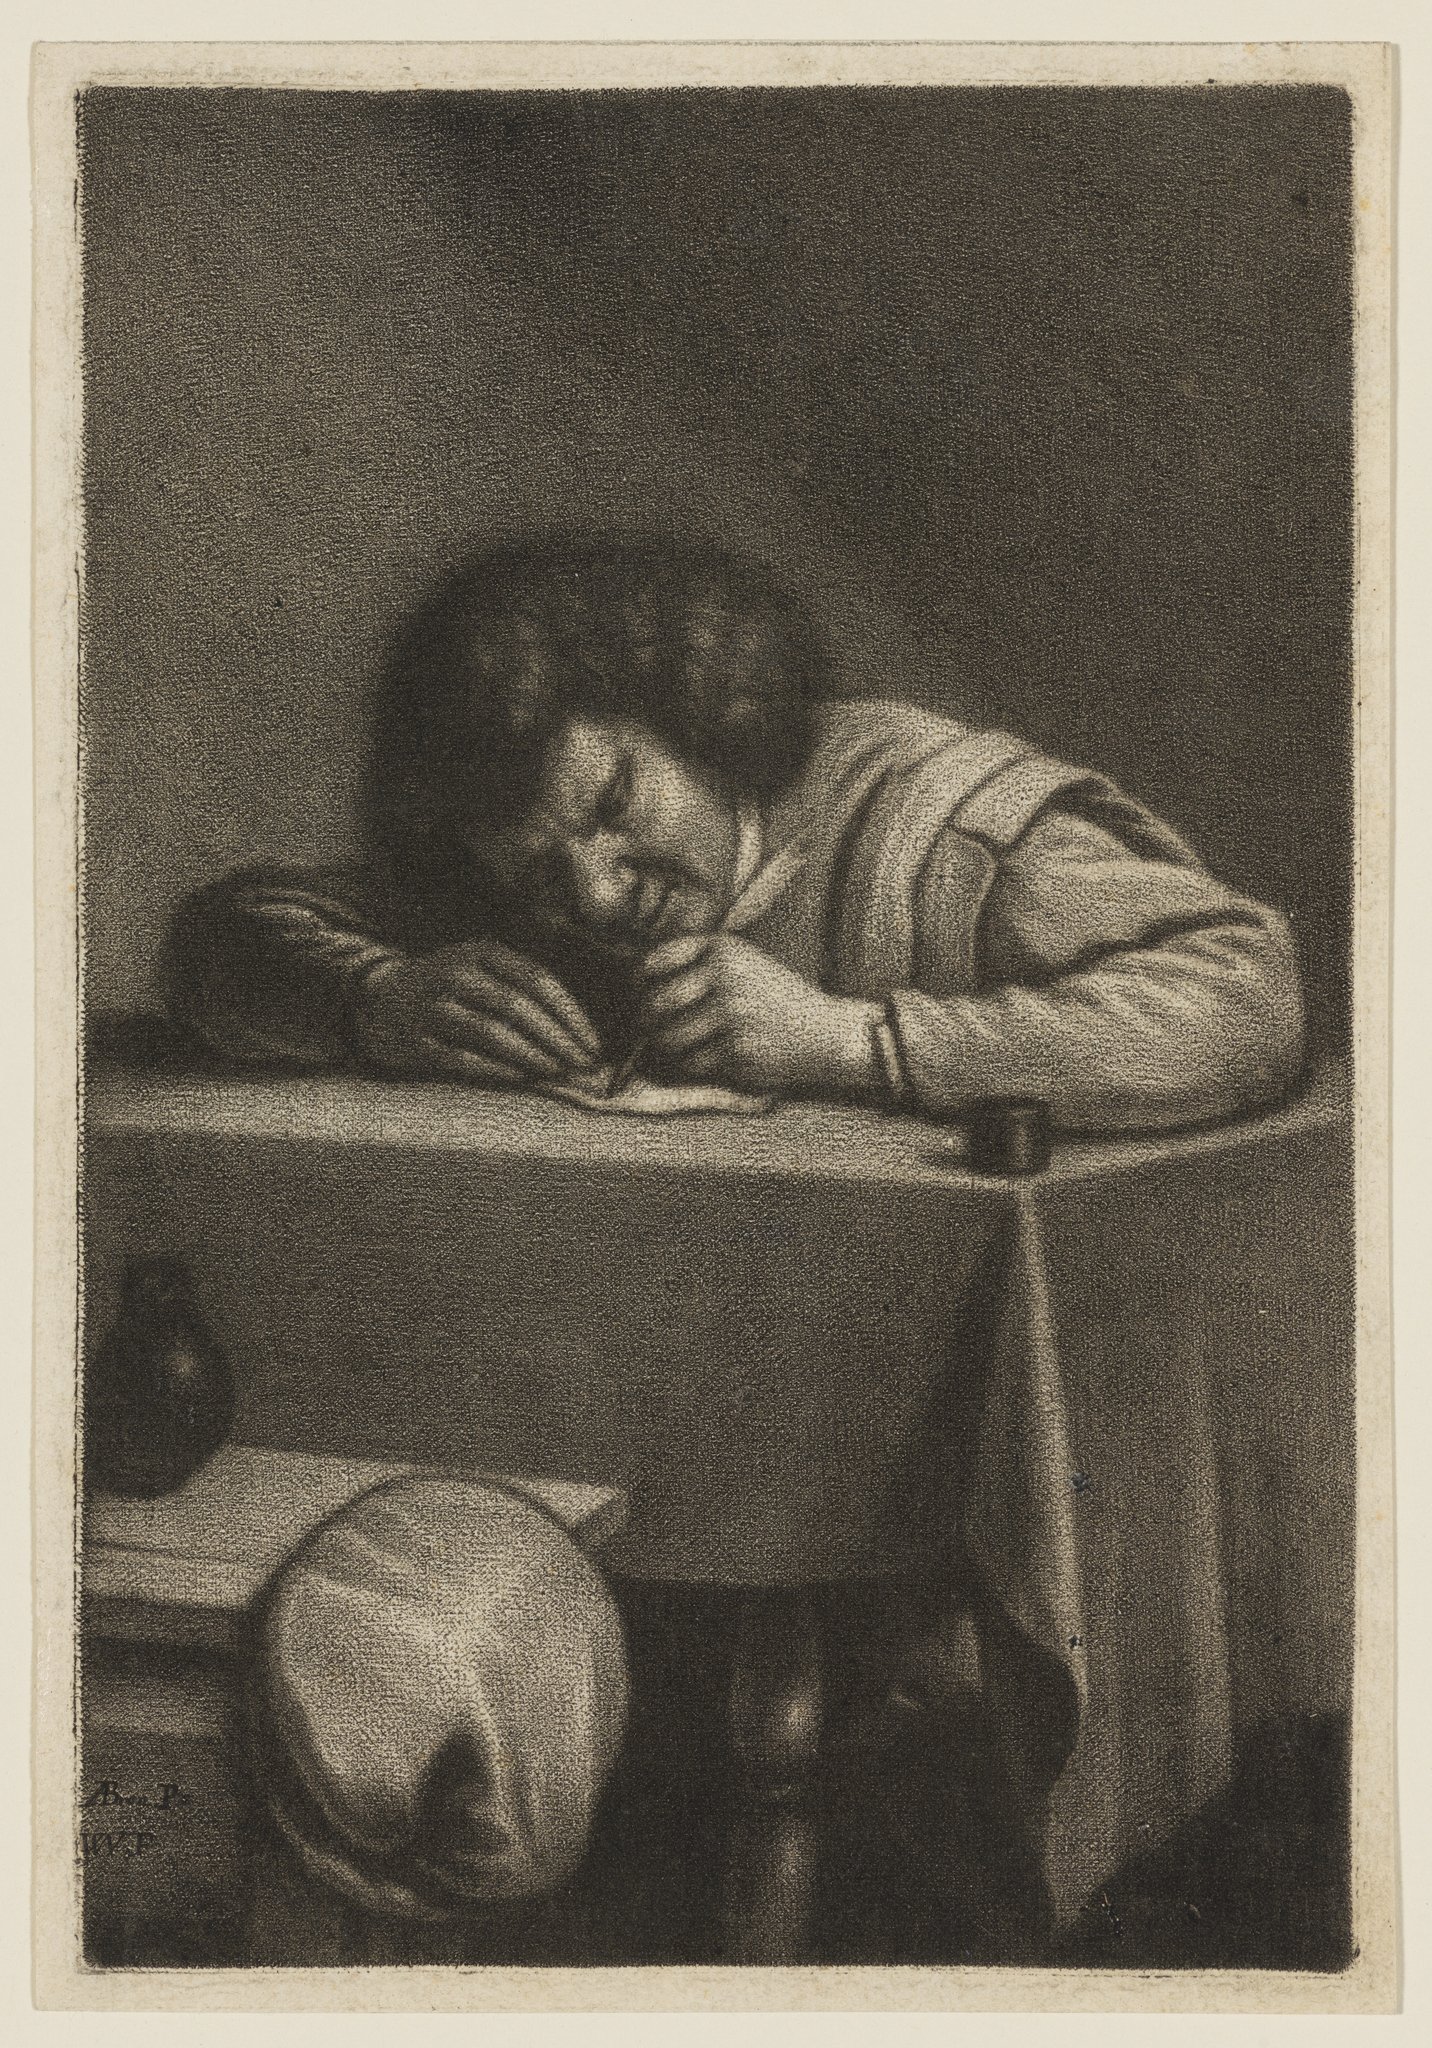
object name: print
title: Man at a Table Writing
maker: wallerant vaillant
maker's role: artist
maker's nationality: dutch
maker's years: 1623-1677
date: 1634-1666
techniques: mezzotint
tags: men,writing